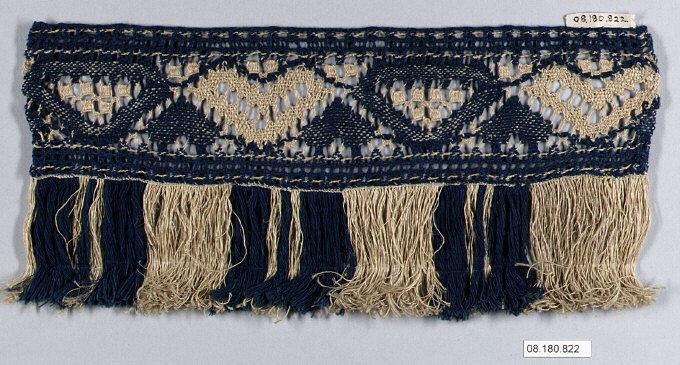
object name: fragment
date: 1801-1900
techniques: lace